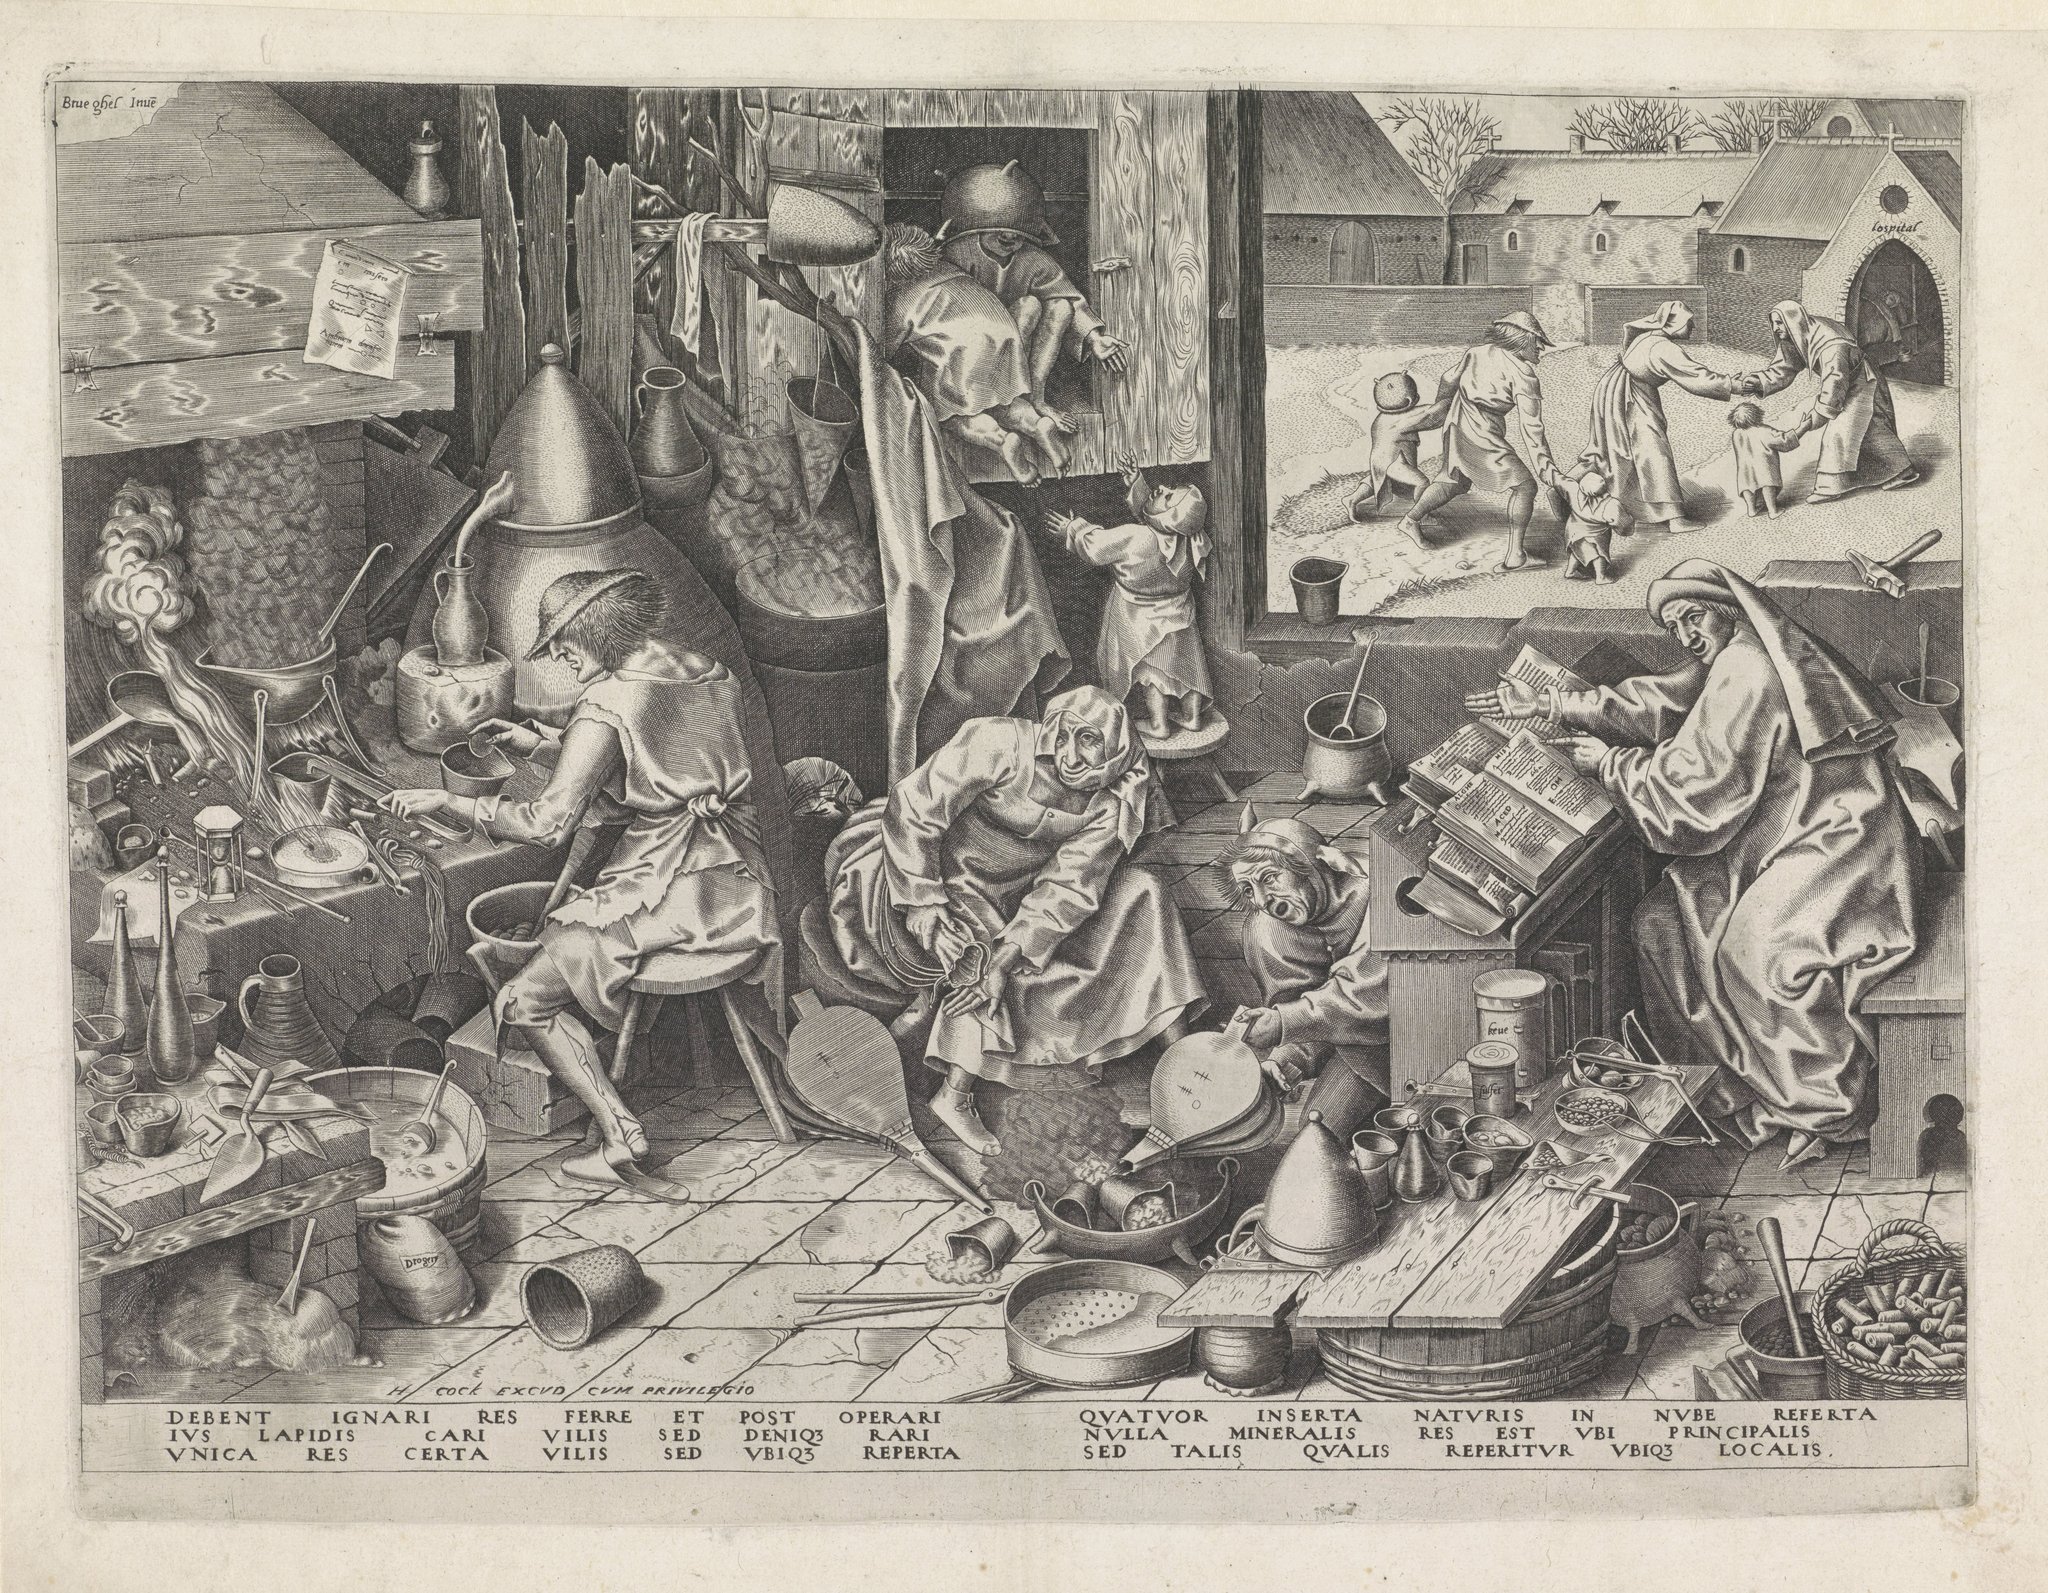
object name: print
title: Alchemist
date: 1556-1560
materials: paper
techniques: engraving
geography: antwerp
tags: book - mm - book open, fire, oven, furnace ~ interior of industrial structure, alchemist at work, bellows, the poor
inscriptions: collector's mark: Lugt 240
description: Gezin van alchemisten aan het werk in een werkplaats. Links is een man bezig metalen te smelten op een fornuis en in het midden wordt met blaasbalgen een vuur opgestookt. Rechts een geleerde achter boeken. Drie kinderen ontsnappen aan de chaos door door een luik te kruipen. Op de achtergrond is te zien hoe het gezin in een gasthuis of ziekenhuis wordt opgevangen. Onder de voorstelling twee drieregelige verzen in het Latijn.